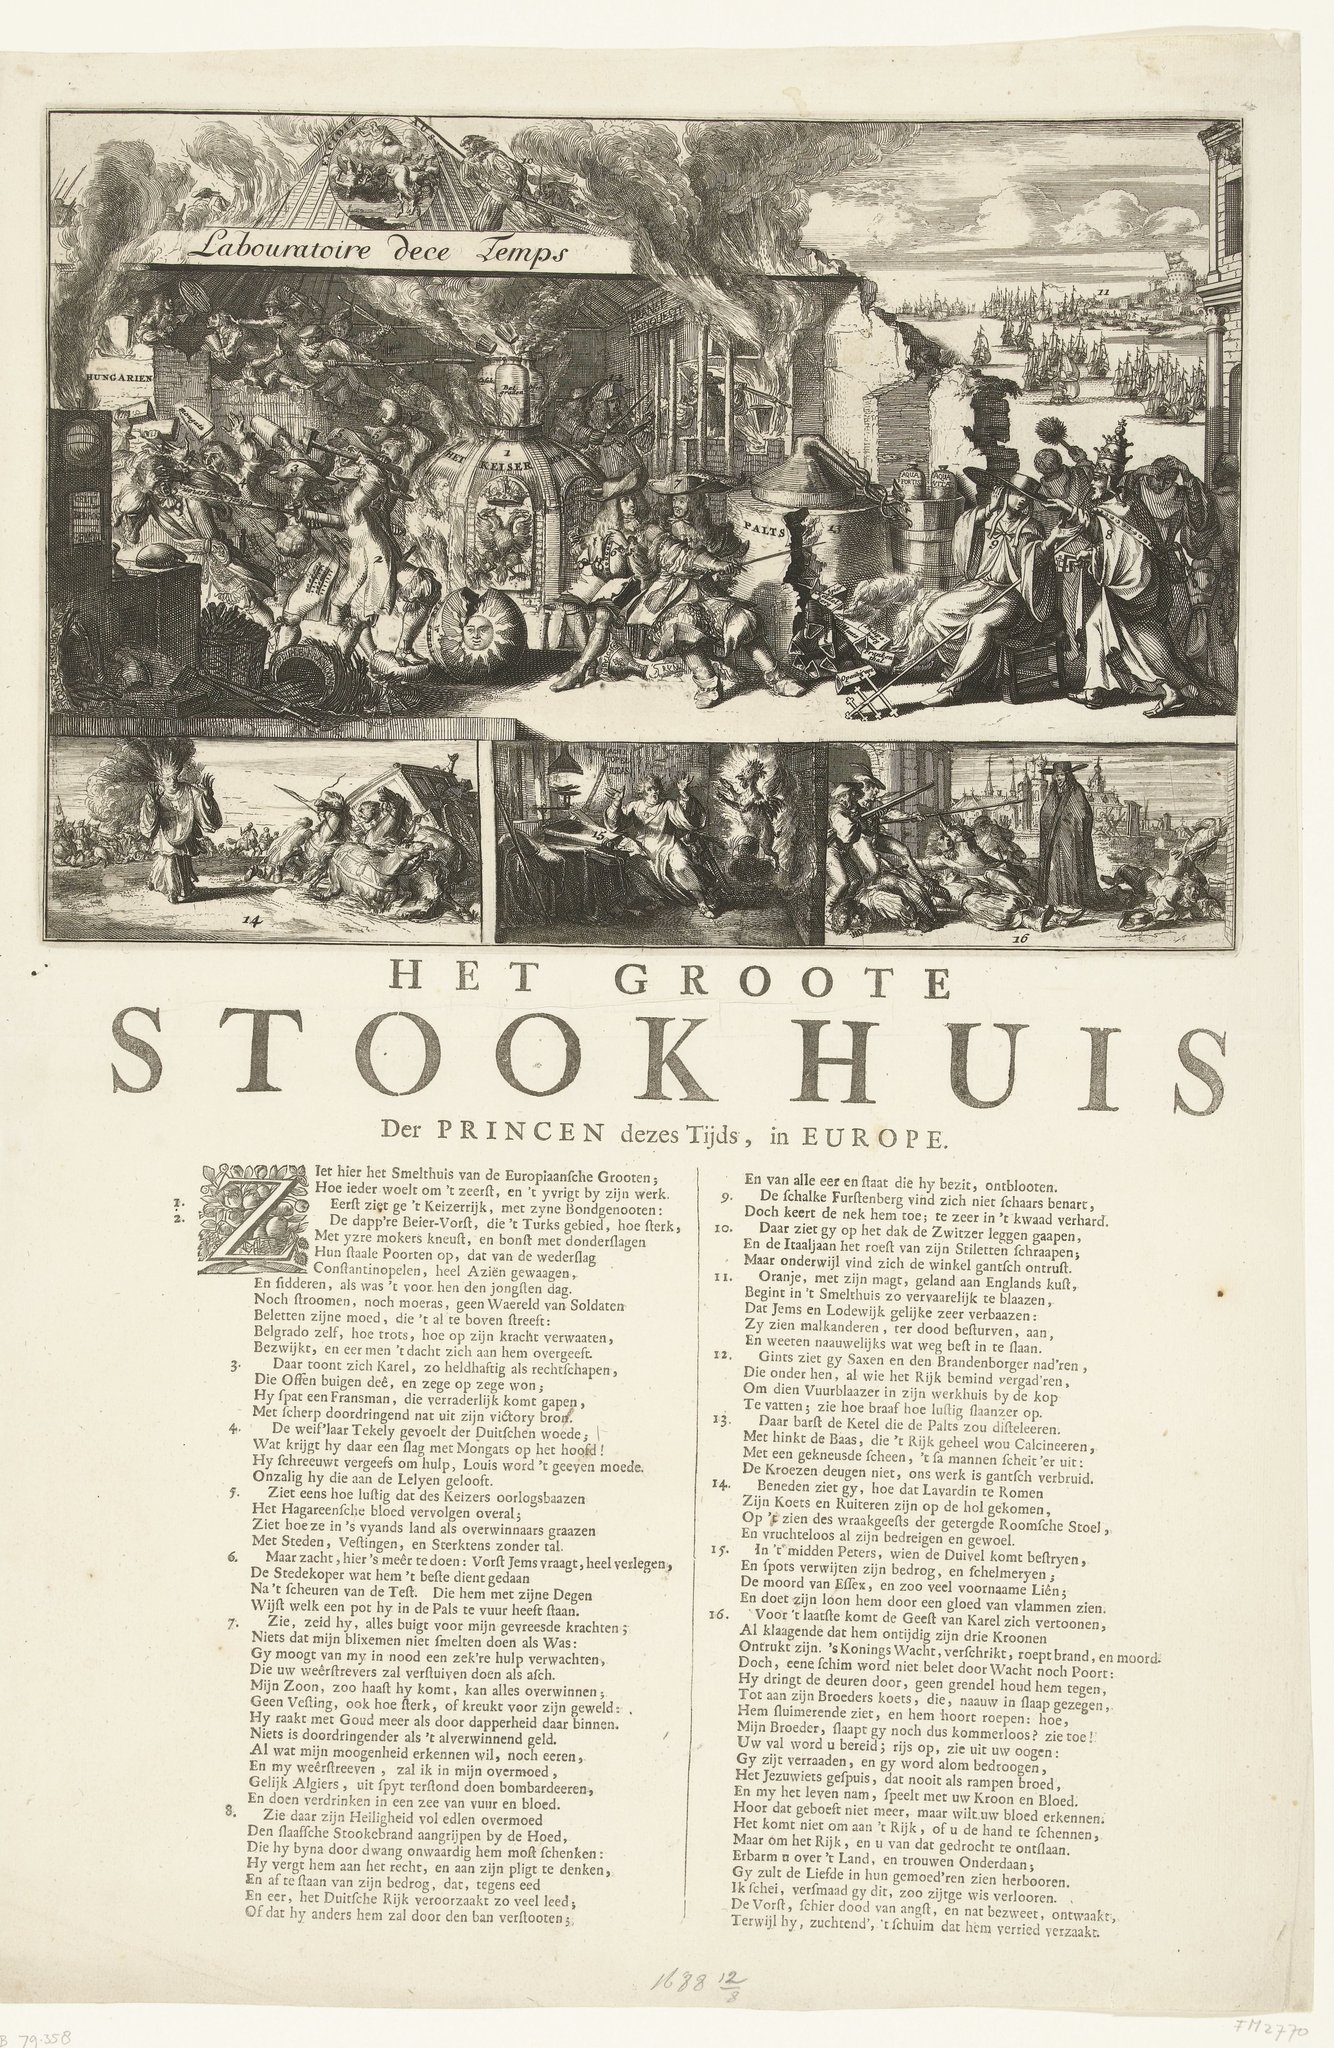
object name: cartoon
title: Het Groote Stookhuis Der Princen dezes Tijds, in Europe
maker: romeyn de hooghe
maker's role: draughtsman, goldsmith, painter, print maker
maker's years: 1645-1708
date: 1688-1689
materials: paper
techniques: engraving, etching, letterpress printing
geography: northern netherlands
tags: jacobus ii (koning van engeland en schotland), lodewijk xiv (koning van frankrijk), paris, london, karel i (koning van engeland), alchemy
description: Spotprent op Jacobus II en Lodewijk XIV als alchemisten, 1688. Alchemistenwerkplaats met een grote ketel waarin het vuur onder het keizerrijk. Rechts probeert de paus de bisschop-kardinaal zijn hoed af te nemen. Op de achtergrond de aankomst van de vloot van Willem III. Hieronder 3 kleine scènes met de verongelukte koets van Lavardin (de Franse gezant te Rome), de duivel verschijnt aan pater Peters (Edward Petre) en de geest van koning Karel I die door de straten dwaalt. Onder de voorstelling een vers in 2 kolommen met een verklaring van de cijfers 1-16 in het Nederlands.